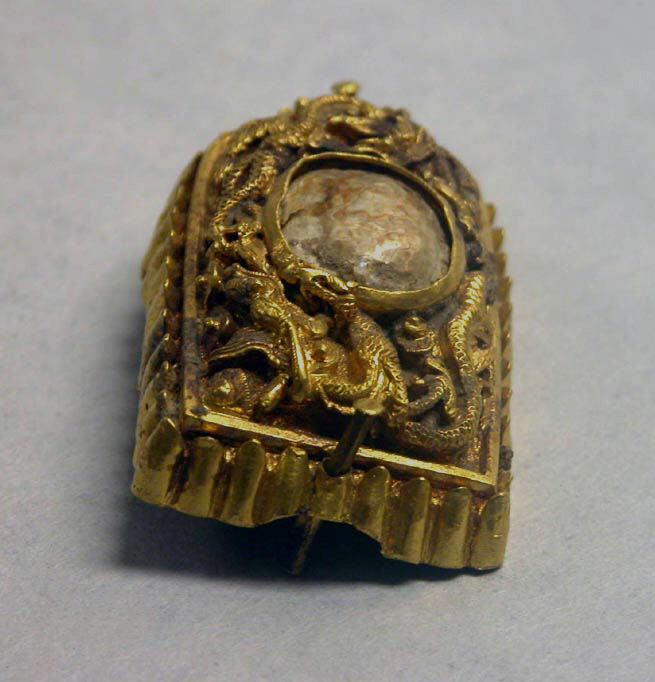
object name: ornament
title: Headdress Ornament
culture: chinese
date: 1368-1644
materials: gold, pearl